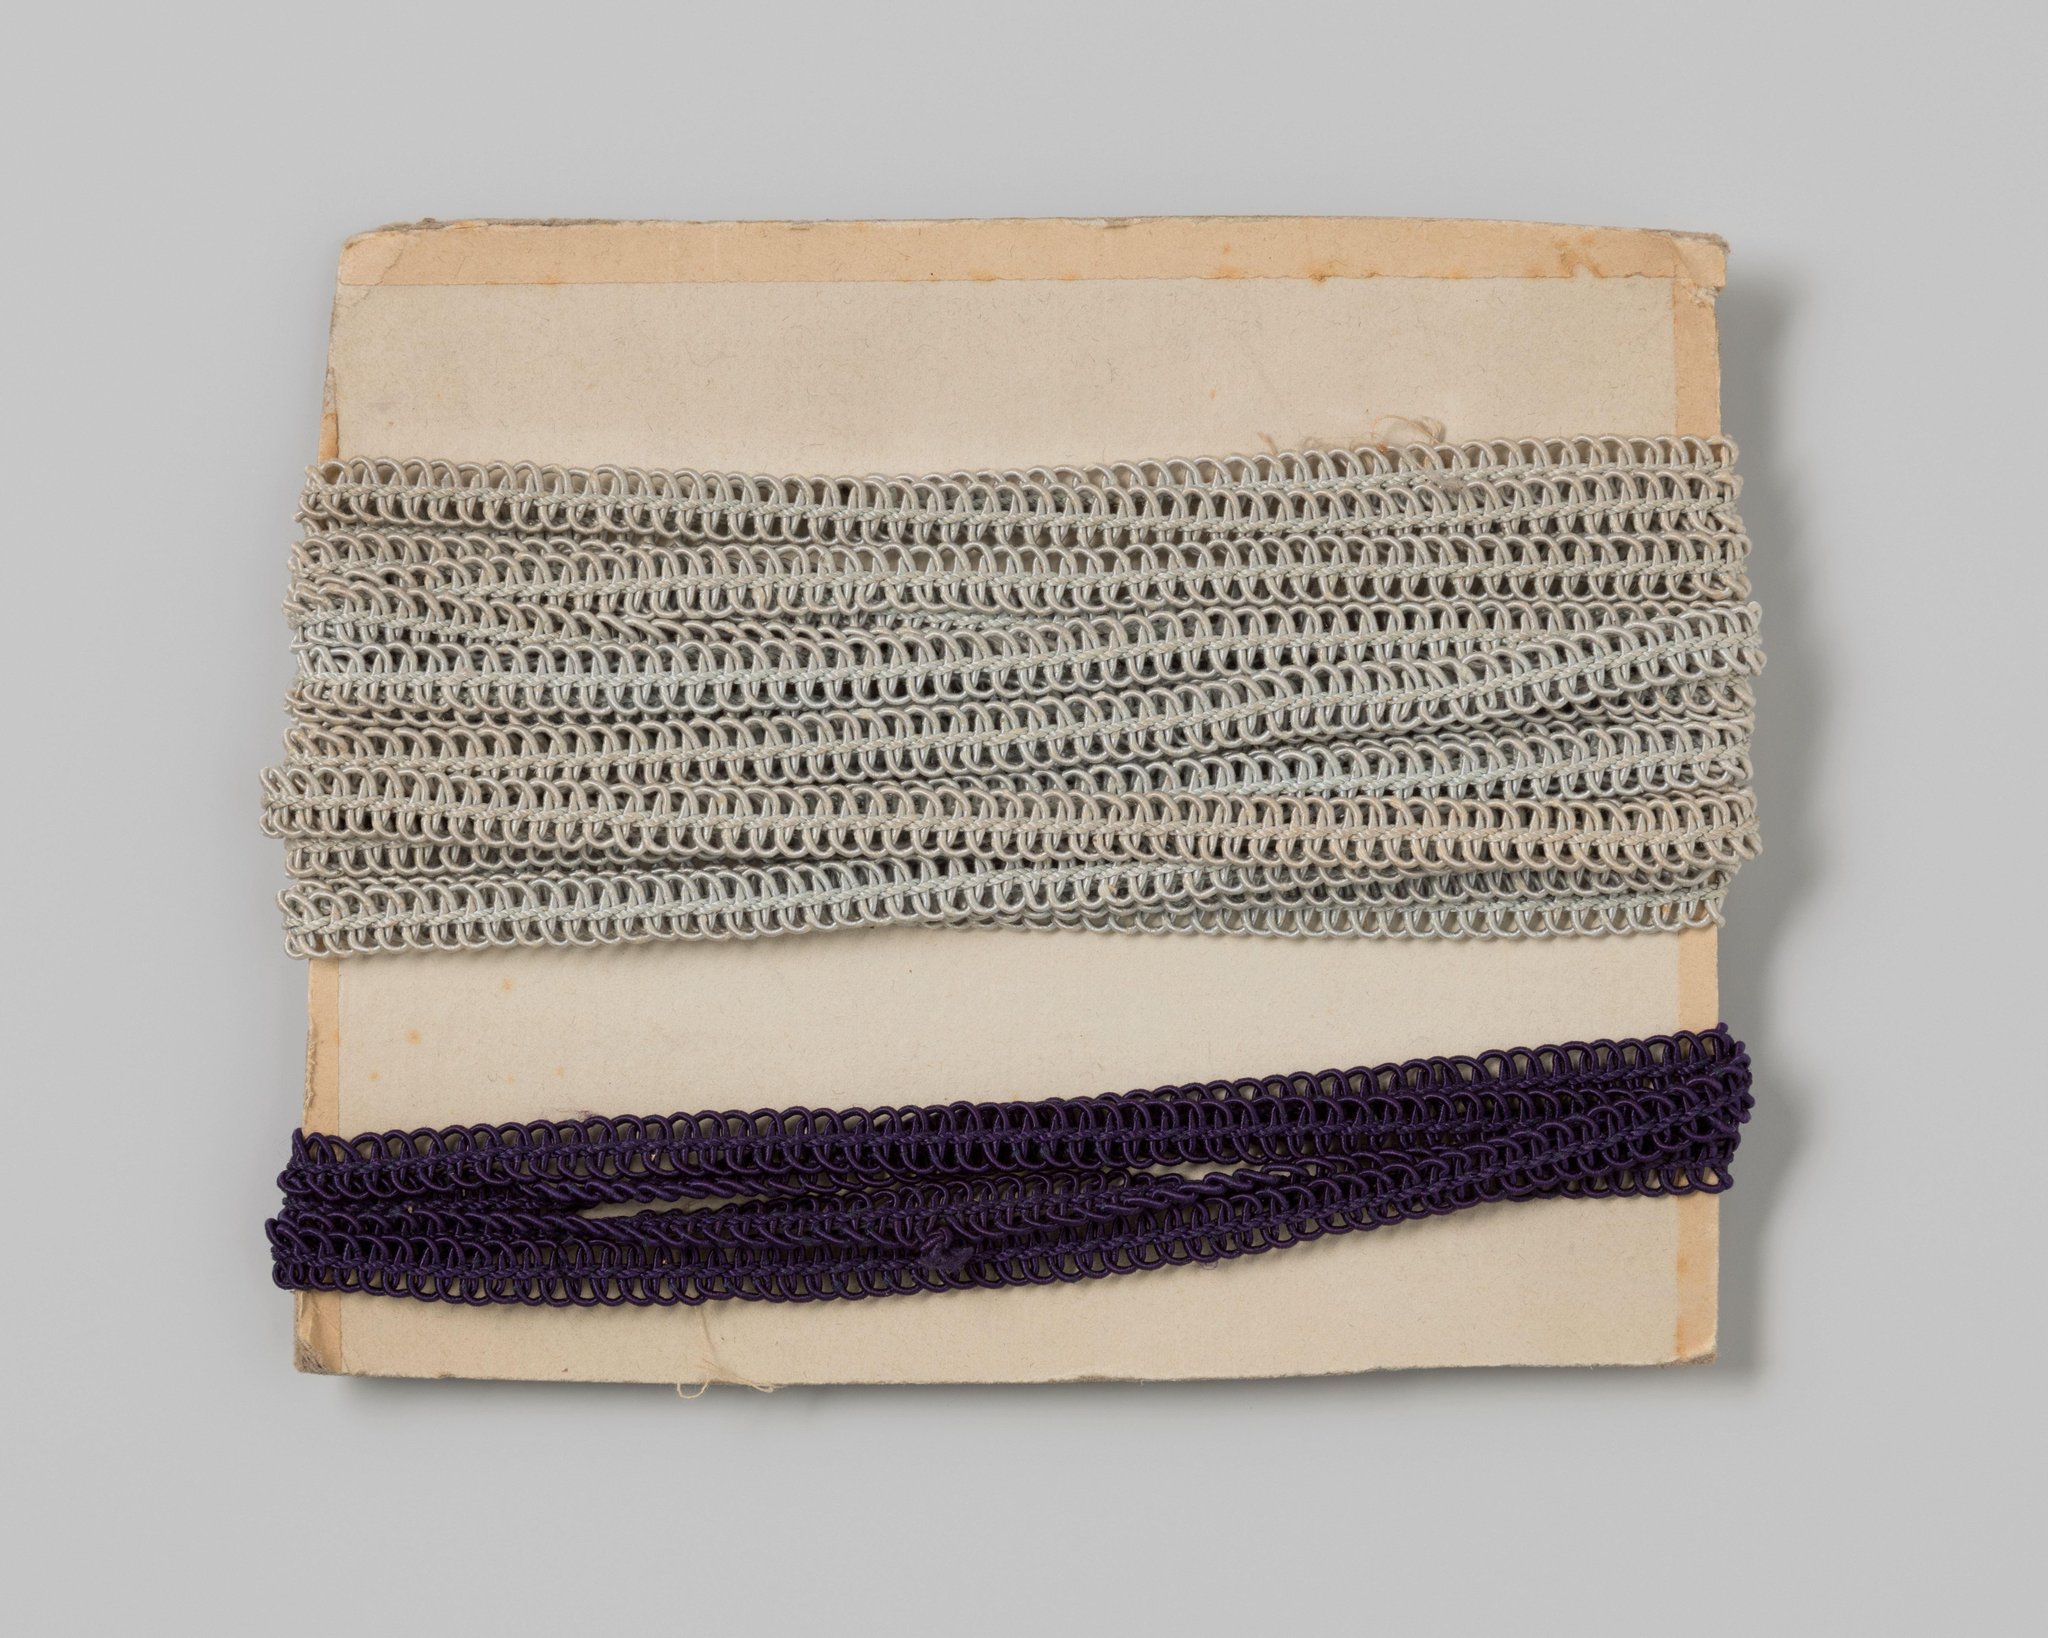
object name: braid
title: Passement van glanzend lichtgroen koord waardoorheen lussen zijn gevlochten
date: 1920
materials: cardboard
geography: nijmegen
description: Passement van glanzend lichtgroen koord waardoorheen lussen zijn gevlochten op karton.